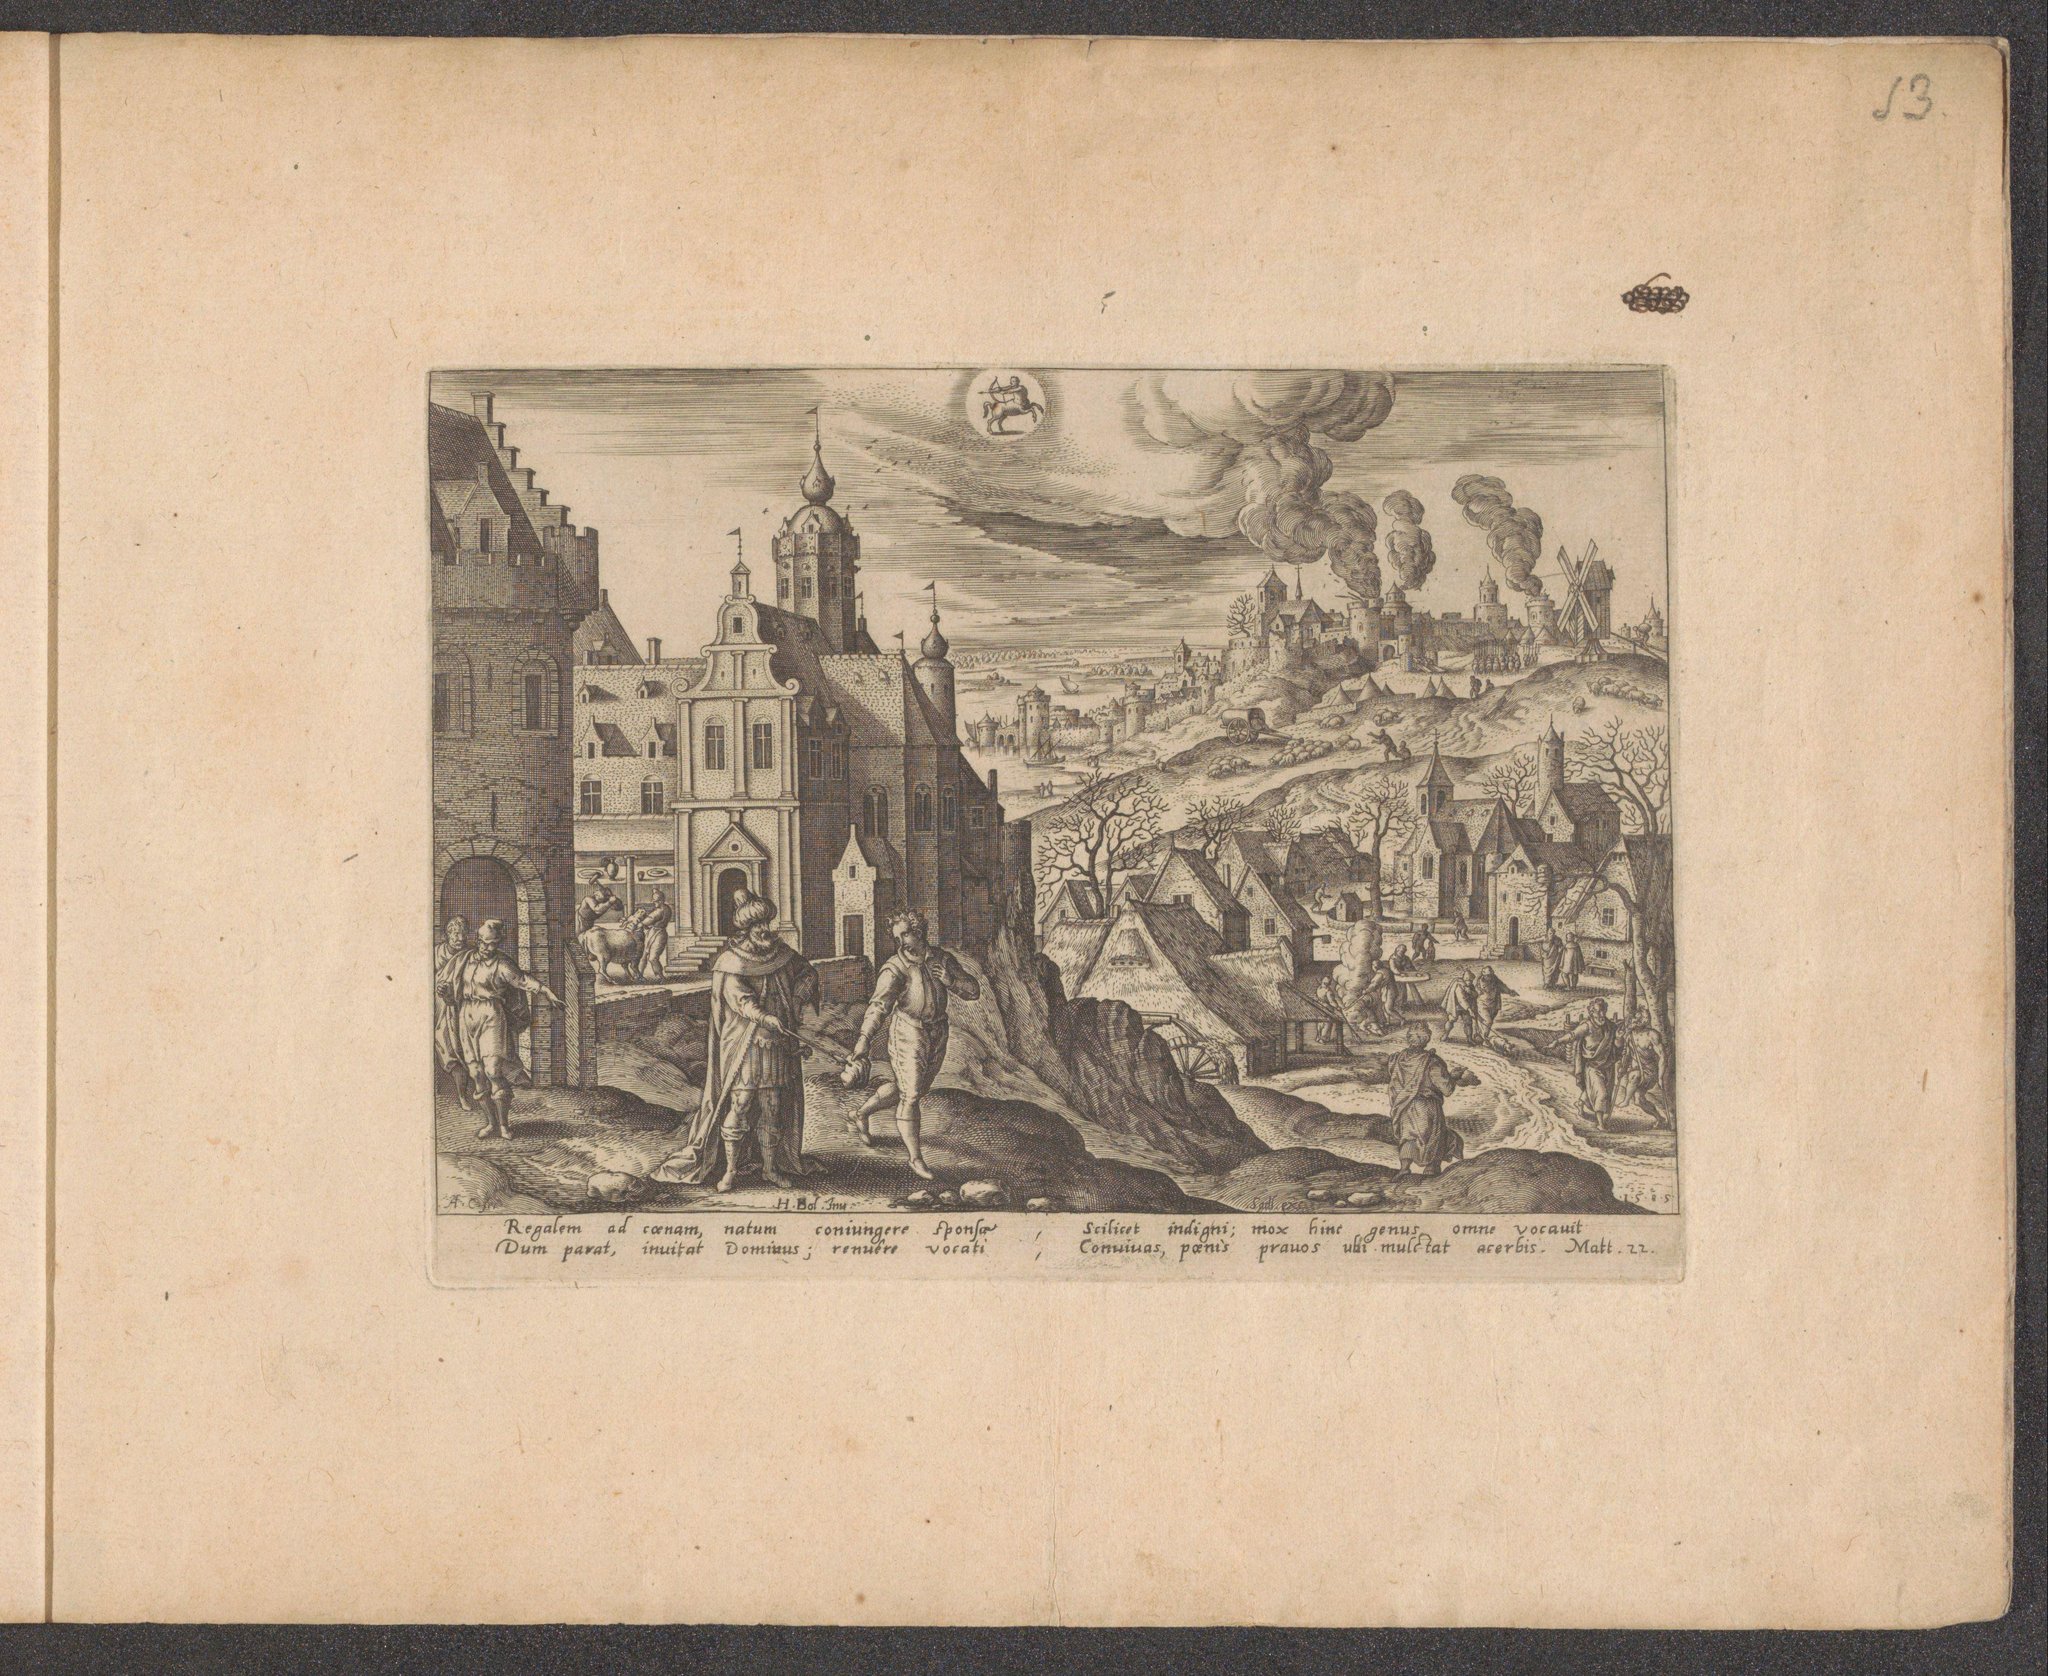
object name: album leaf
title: November: parabel van het bruiloftsfeest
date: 1585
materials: paper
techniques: engraving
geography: antwerp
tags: landscape symbolizing november, november ~ other concepts (+ with zodiacal signs), sagittarius (zodiacal sign of november), village, the great supper; the royal wedding-feast ~ parable of christ (matthew 22:1-14; luke 14:16-24), when informed of the slaying the king takes revenge on the unwilling guests by setting their city on fire ~ parable of the royal wedding feast, poor, maimed, blind and lame are brought in, and sit down at the table ~ parable of the royal wedding-feast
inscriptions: date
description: Middenboven het sterrenbeeld Boogschutter. Op de voorgrond de verbeelding van de parabel van het bruiloftsfeest. Een koning stuurt boodschappers uit om iedereen uit te nodigen voor een groot feest voor het huwelijk van zijn zoon. Op de achtergrond staat de stad in brand van eerdere genodigden die weigerden te komen. De koning stuurde daarom troepen naar de stad om ze te belegeren en haar plat te branden. Onder de voorstelling vier regels Latijn in twee kolommen. De prent maakt deel uit van een album.